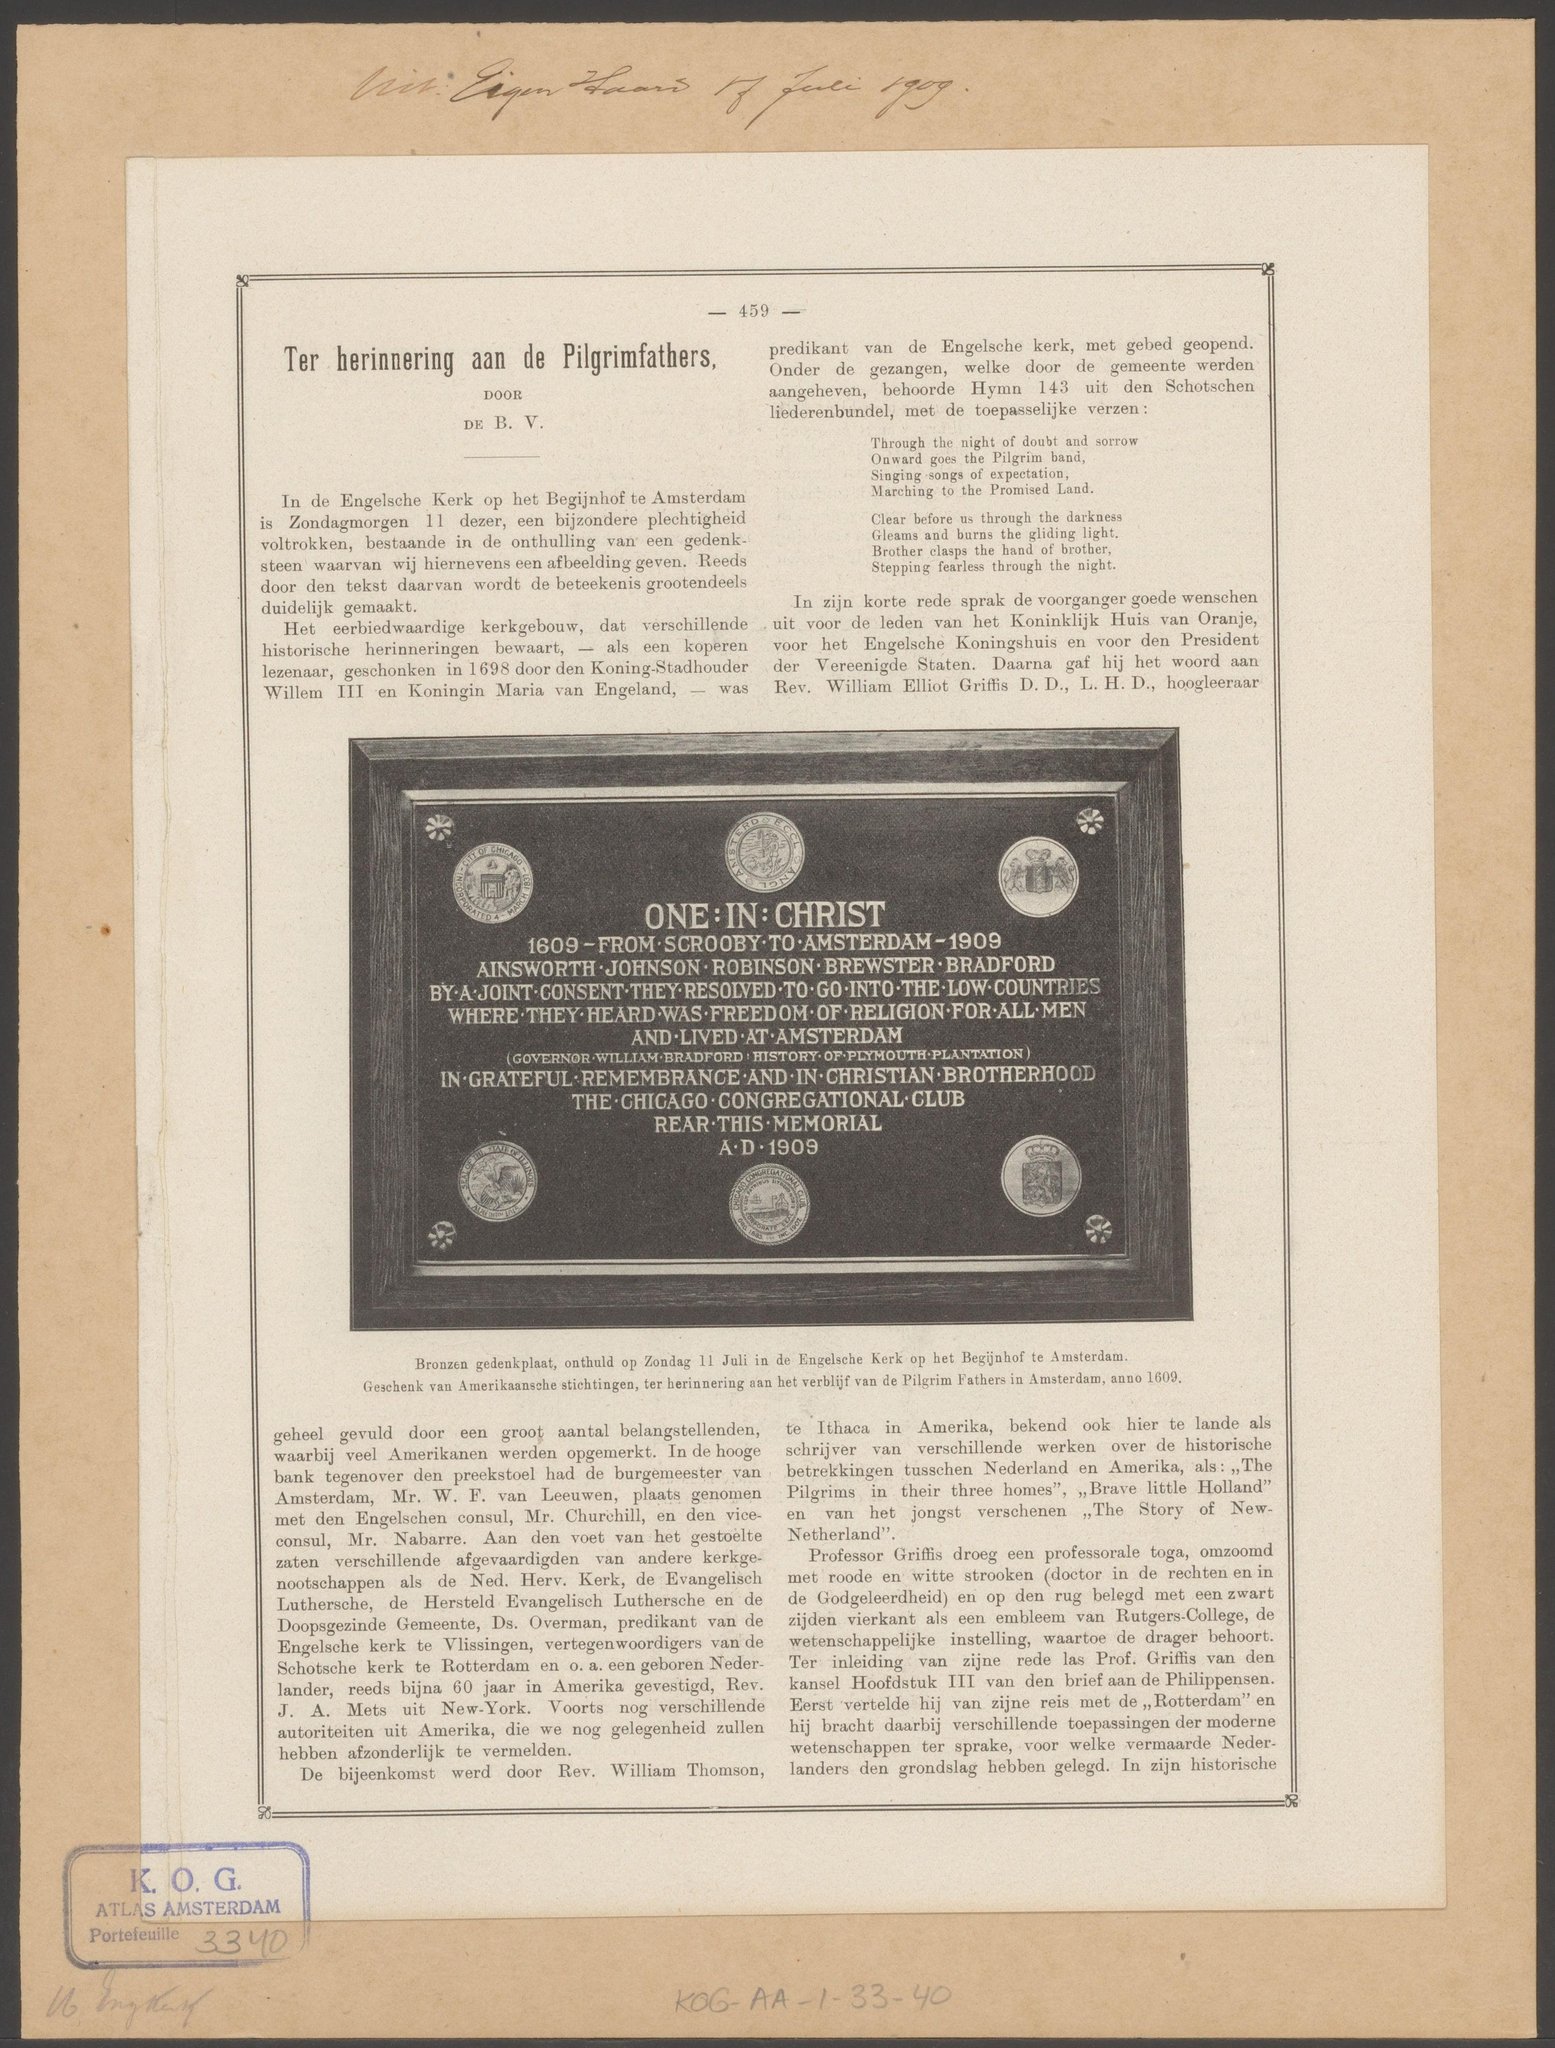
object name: photomechanical print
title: Artikel over de Pilgrim Fathers in de Engelse Kerk te Amsterdam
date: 1909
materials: paper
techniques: letterpress printing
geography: netherlands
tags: beguines, church (exterior), commemoration, jubilee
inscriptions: signature: ‘de B.V.’, collector's mark: Lugt 1641b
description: Object bestaat uit anderhalf blad, met fotomechanische afdrukken op pagina 459-461. Onderwerpsrubriek binnen de Atlas Amsterdam: Kerkwezen: Hervormde Gemeente: Engels Hervormde Gemeente.